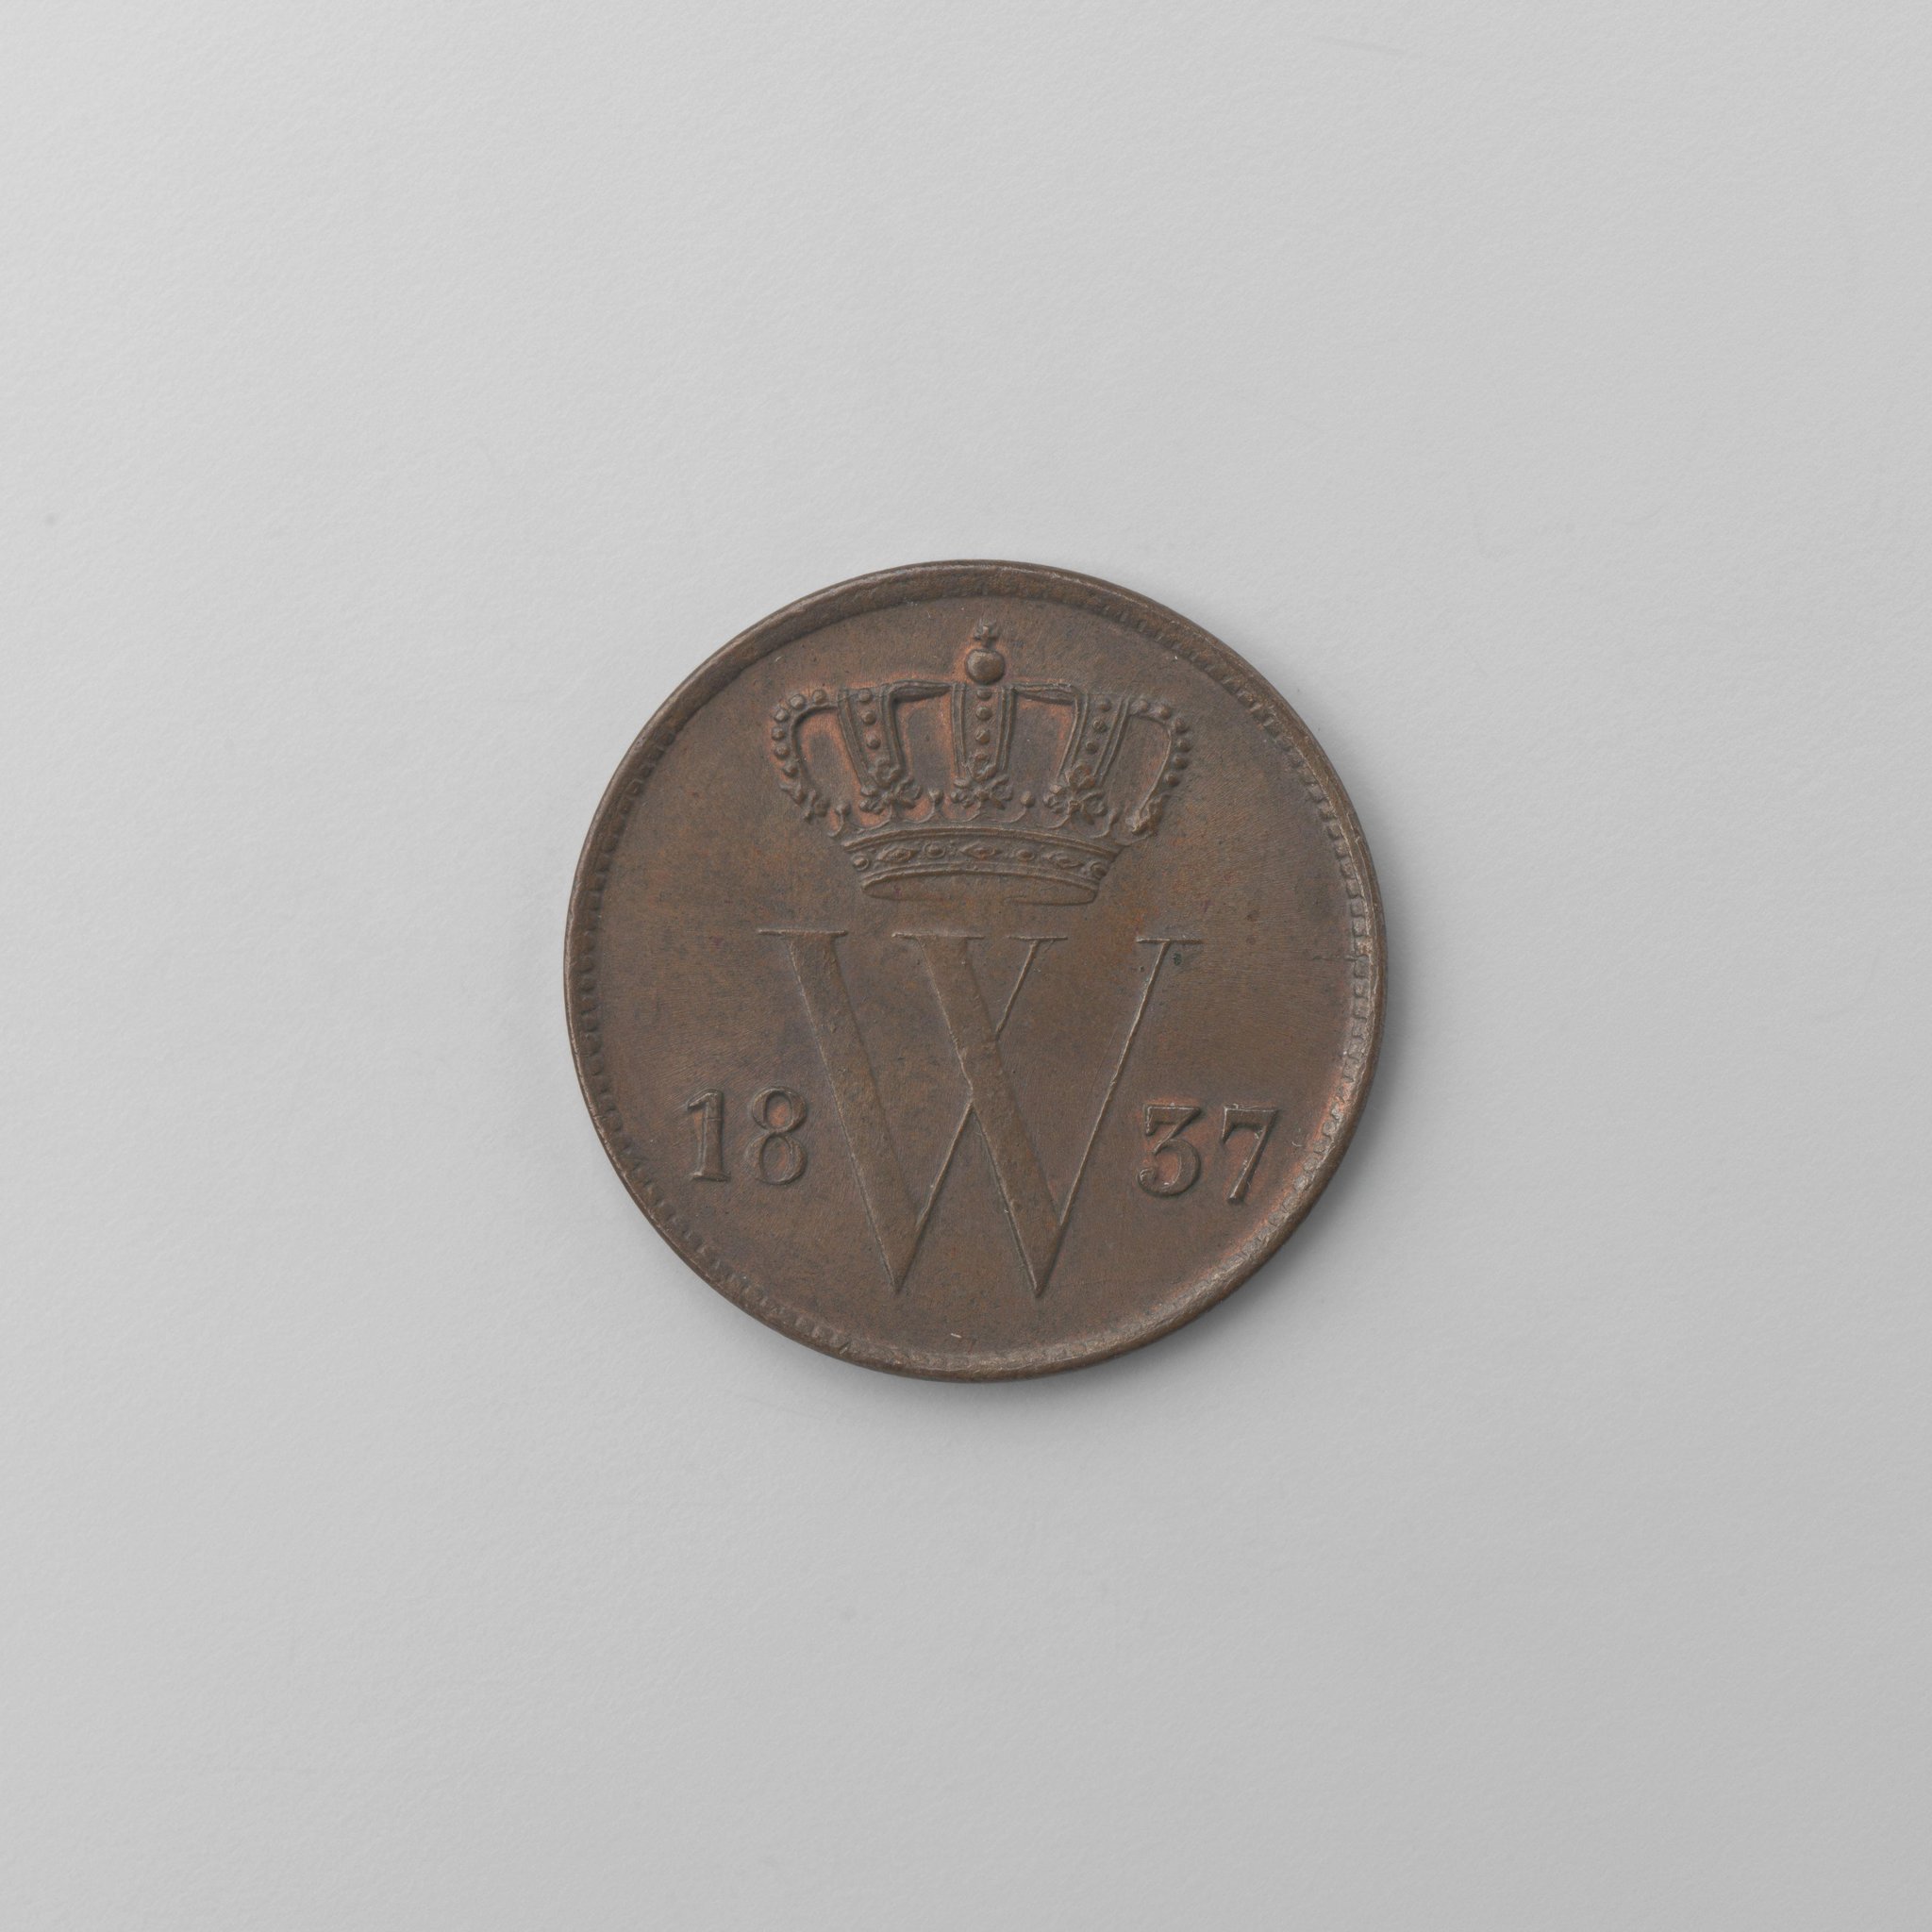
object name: coin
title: Nederland, cent, 1837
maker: william i of the netherlands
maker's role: koning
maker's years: 1772-1843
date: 1837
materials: copper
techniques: striking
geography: utrecht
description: Koperen munt. Voorzijde: tussen jaartal gekroonde rechte letter W. Keerzijde: tussen waarde-aanduiding 1 C. gekroond rijkswapenschild. Gladde rand.